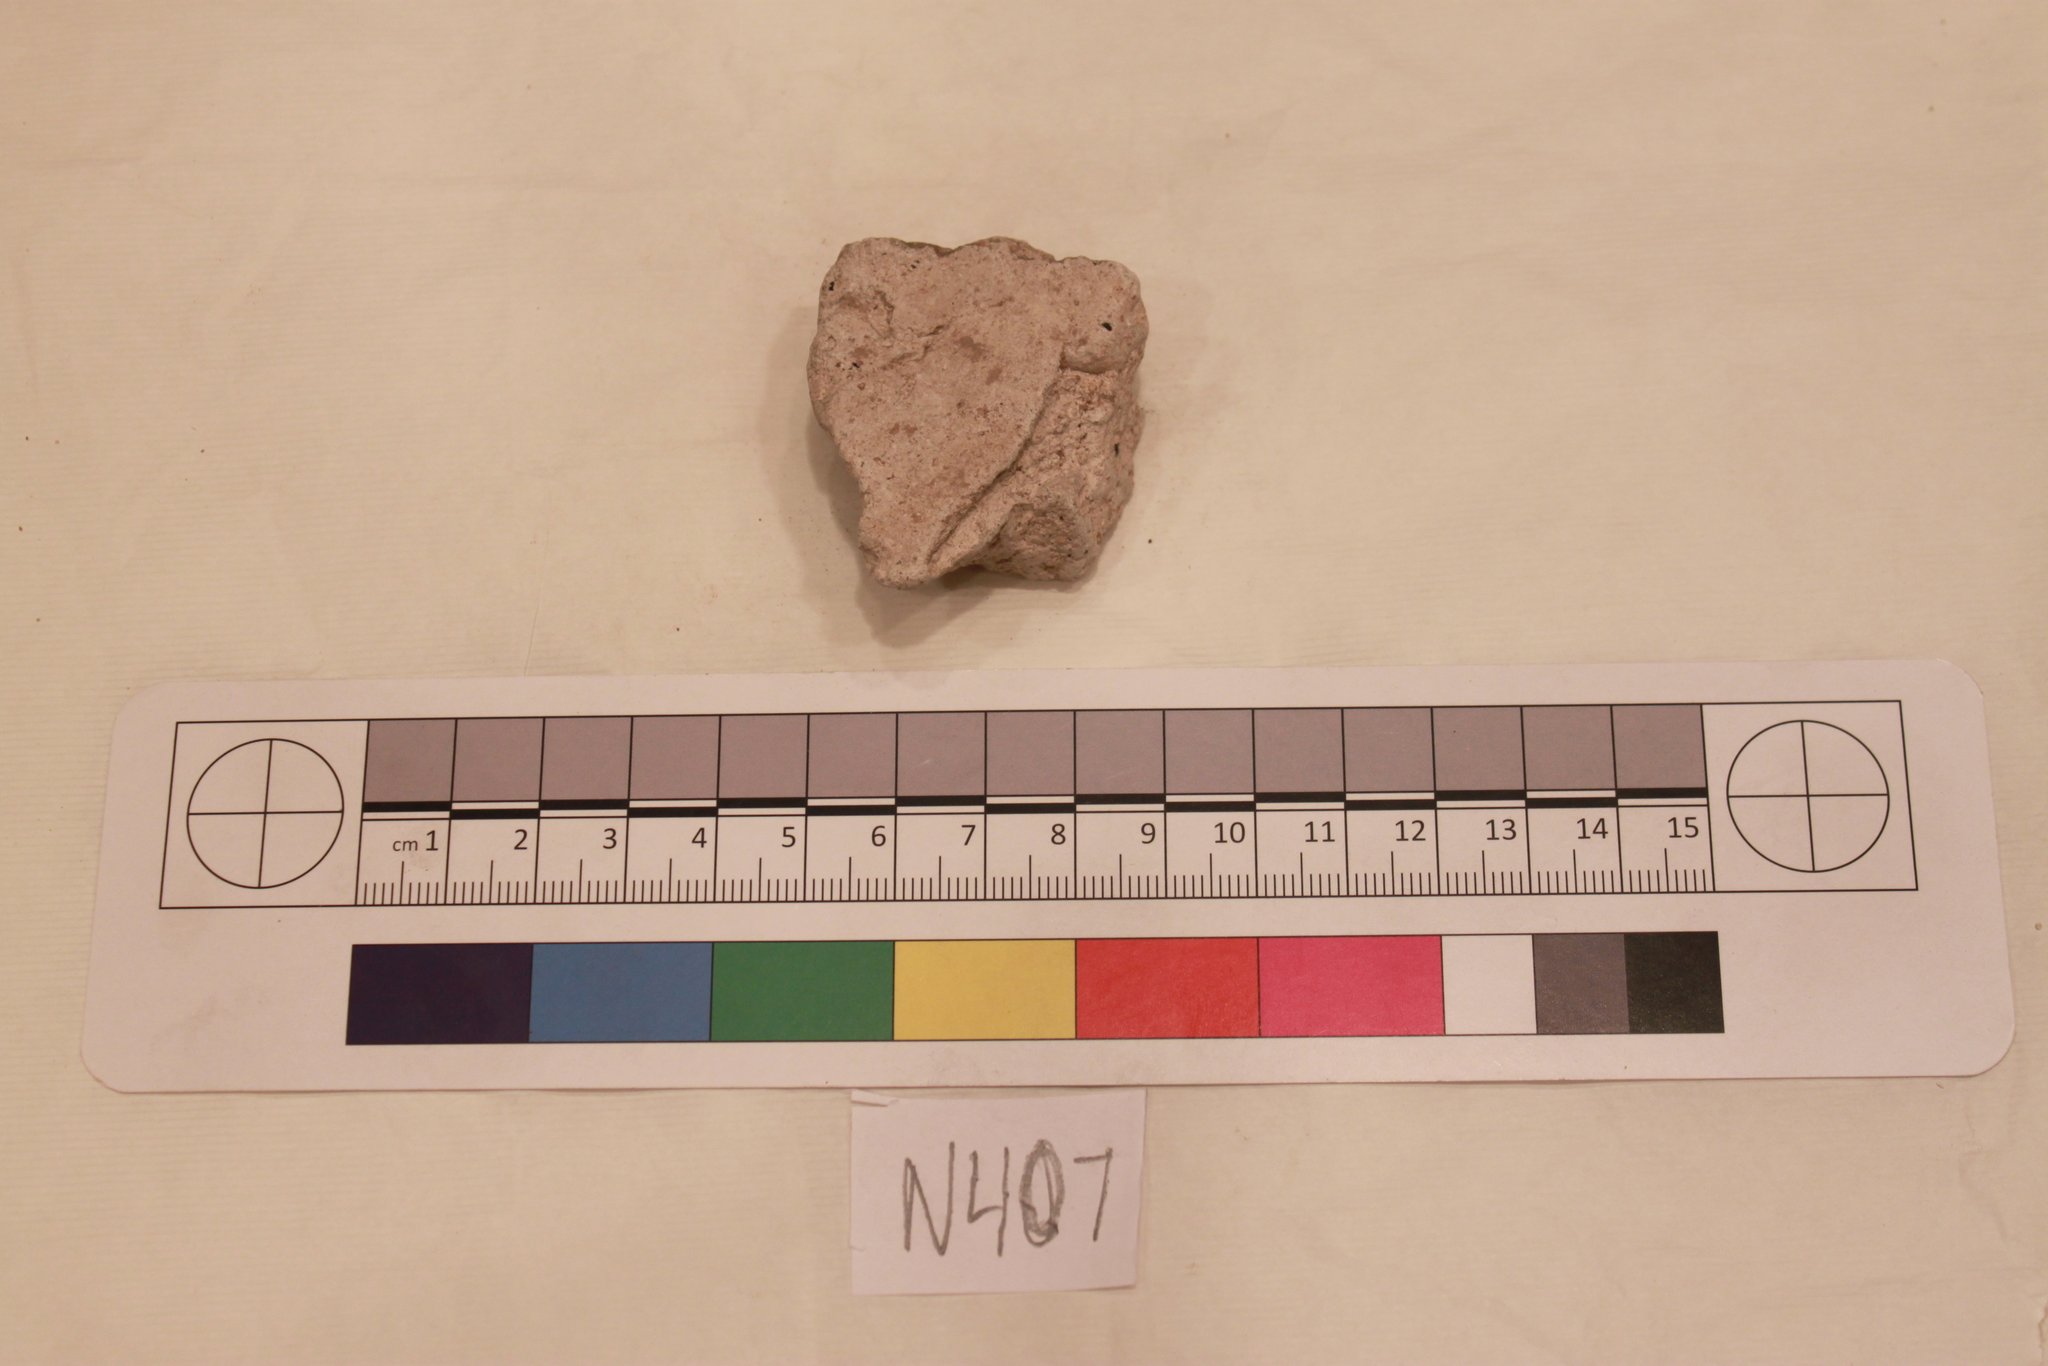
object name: fragment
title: Stucco Fragment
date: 701-1200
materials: plaster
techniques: carving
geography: iran